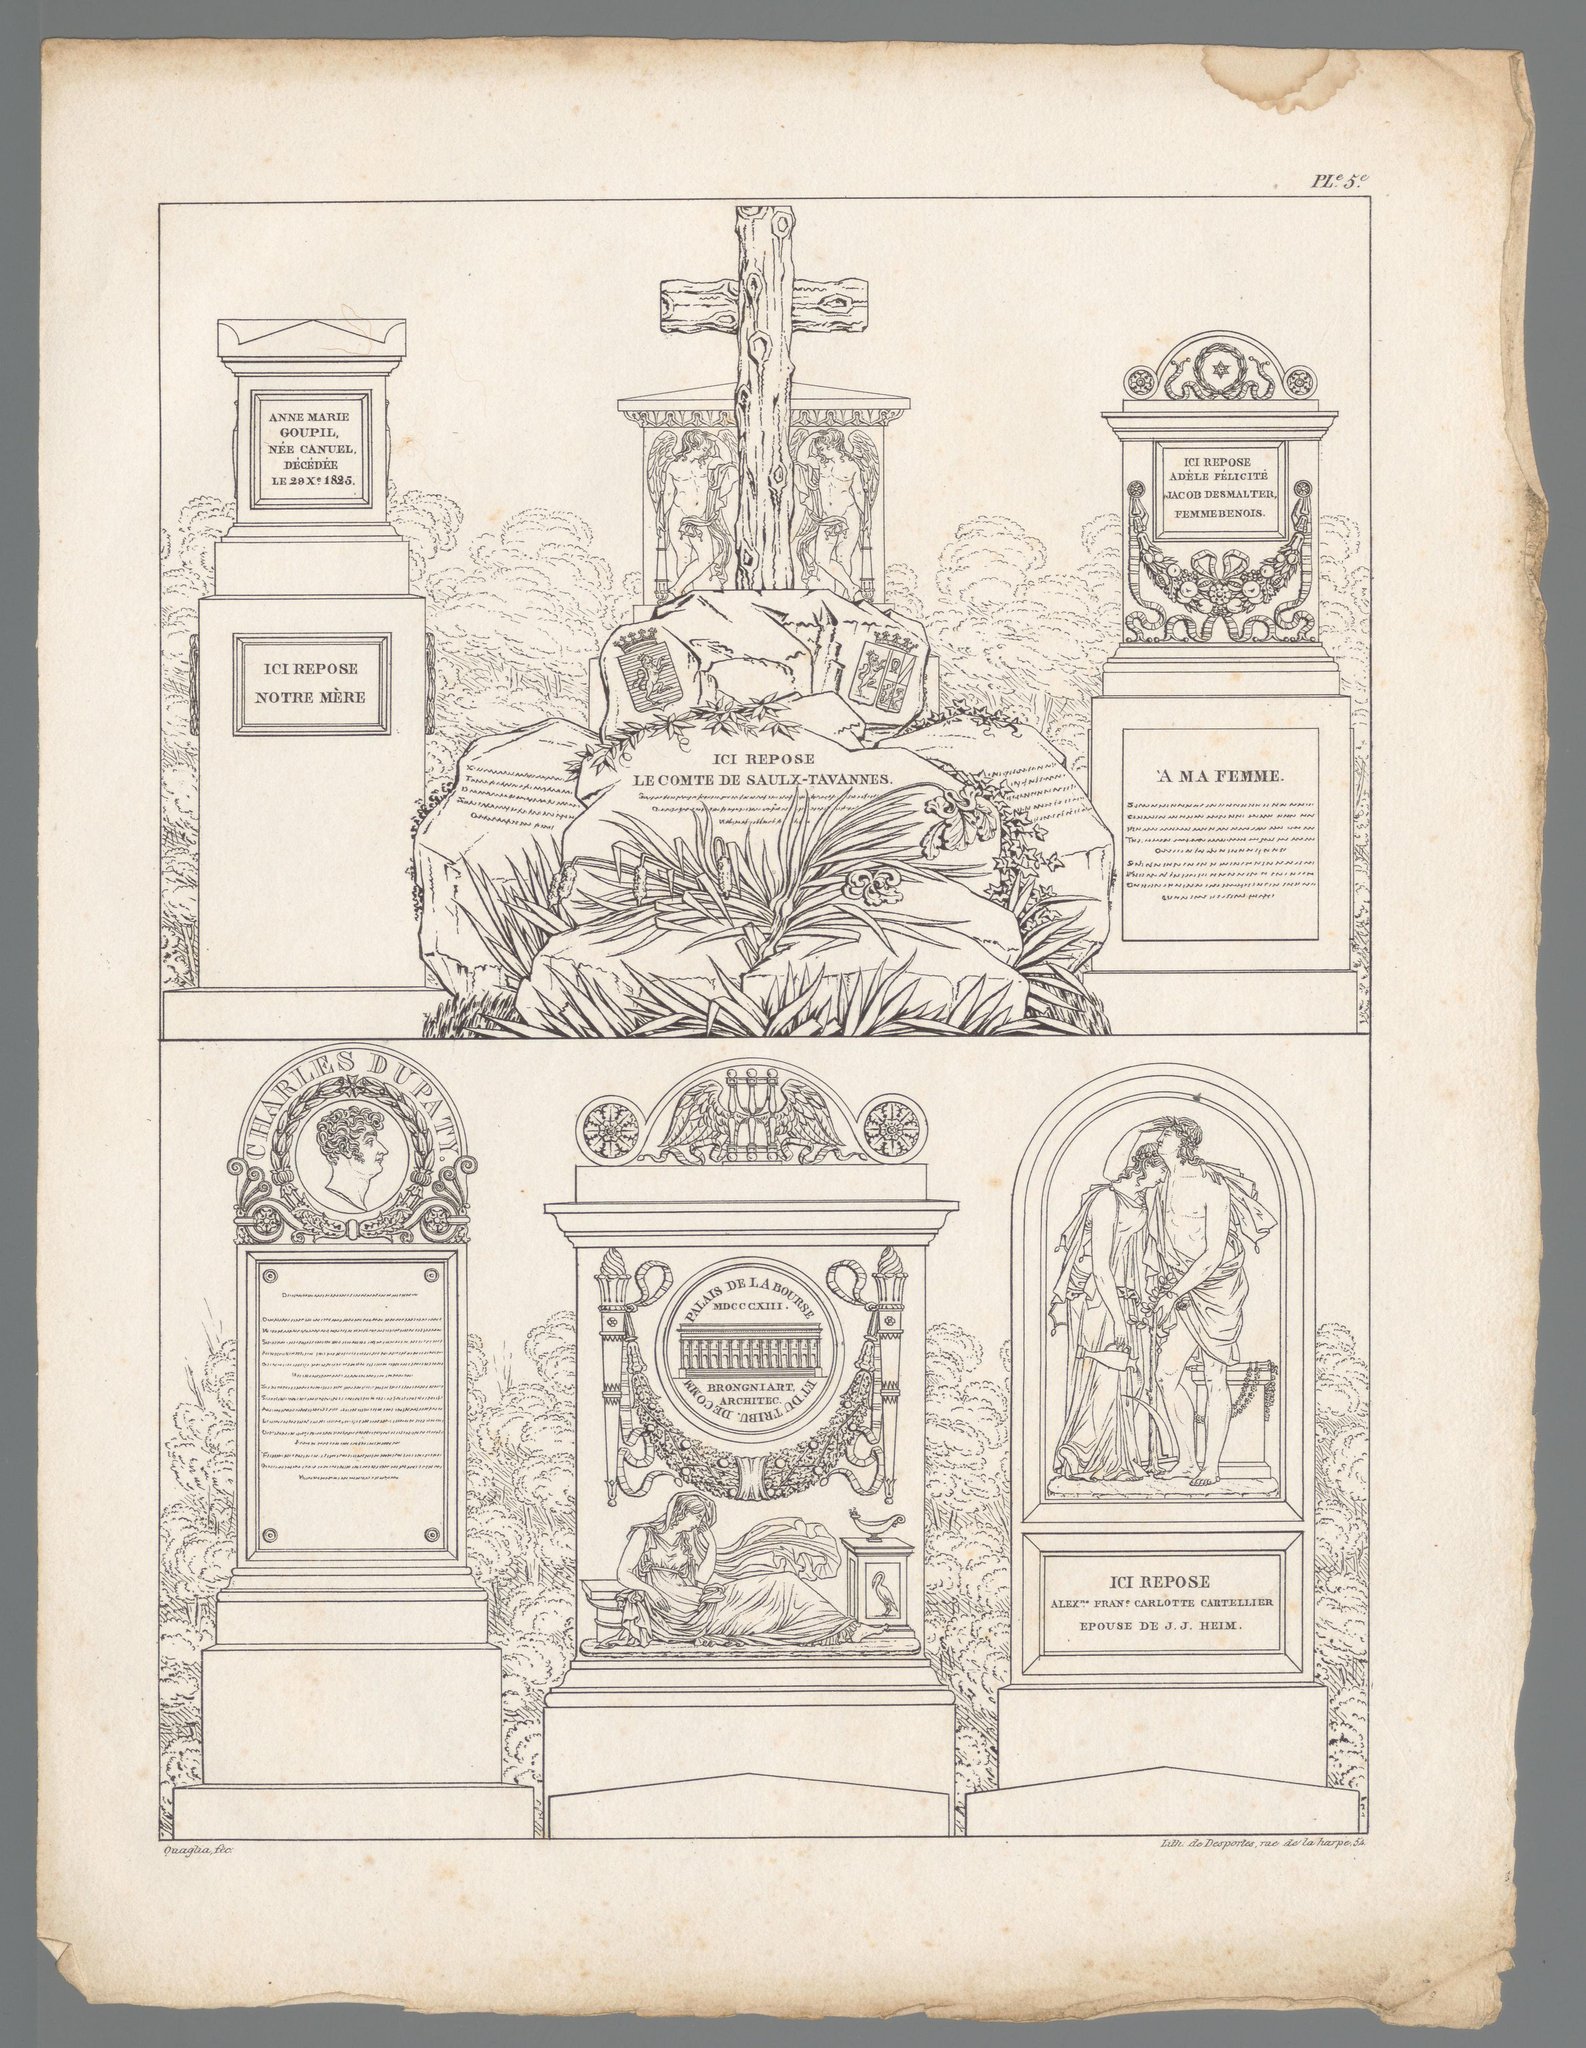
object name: print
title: Zes grafmonumenten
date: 1803-1869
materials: paper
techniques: lithograph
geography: paris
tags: cemetery, park-like burying ground